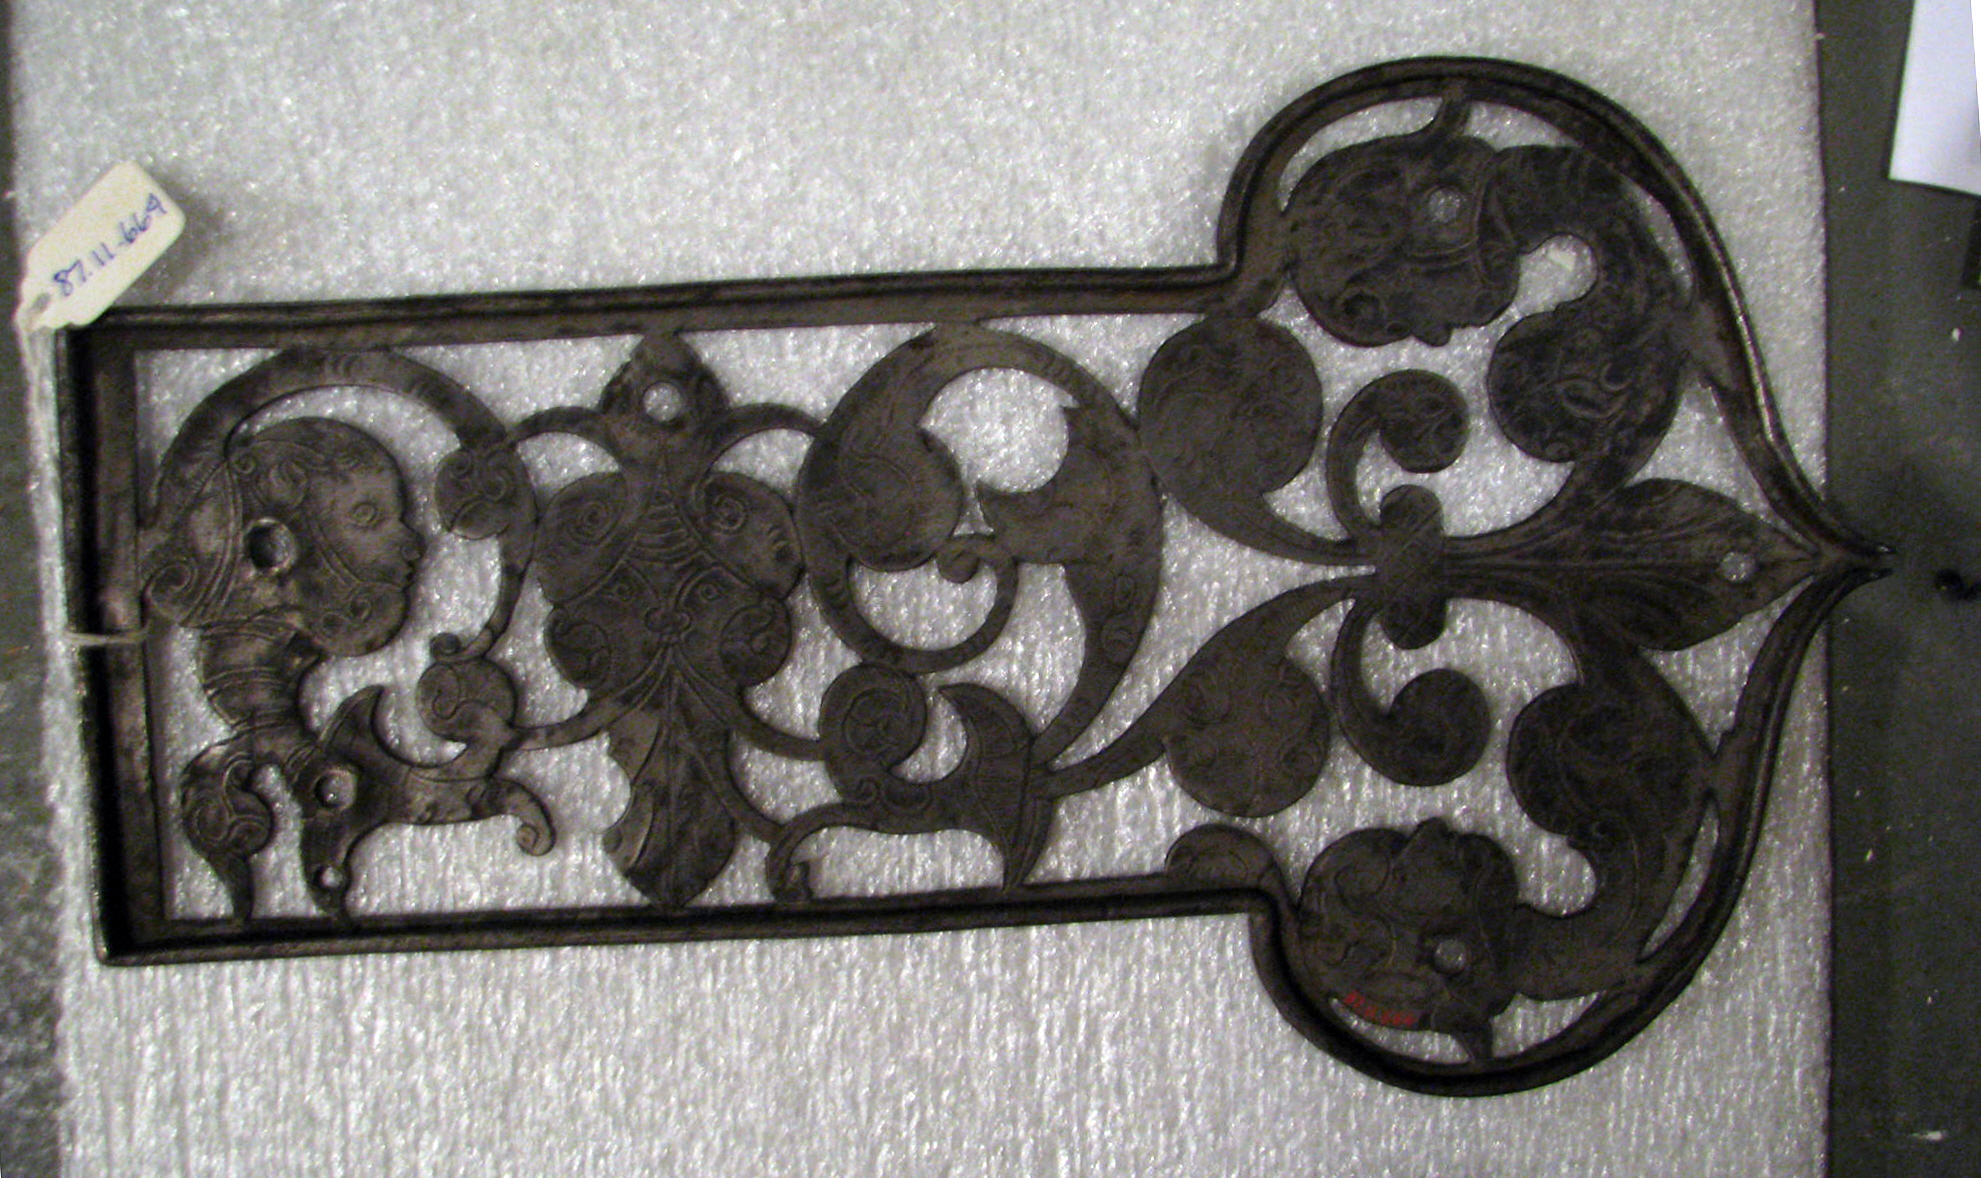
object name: box top plate of rim lock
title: Box-top plate of rim lock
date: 1580-1620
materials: iron